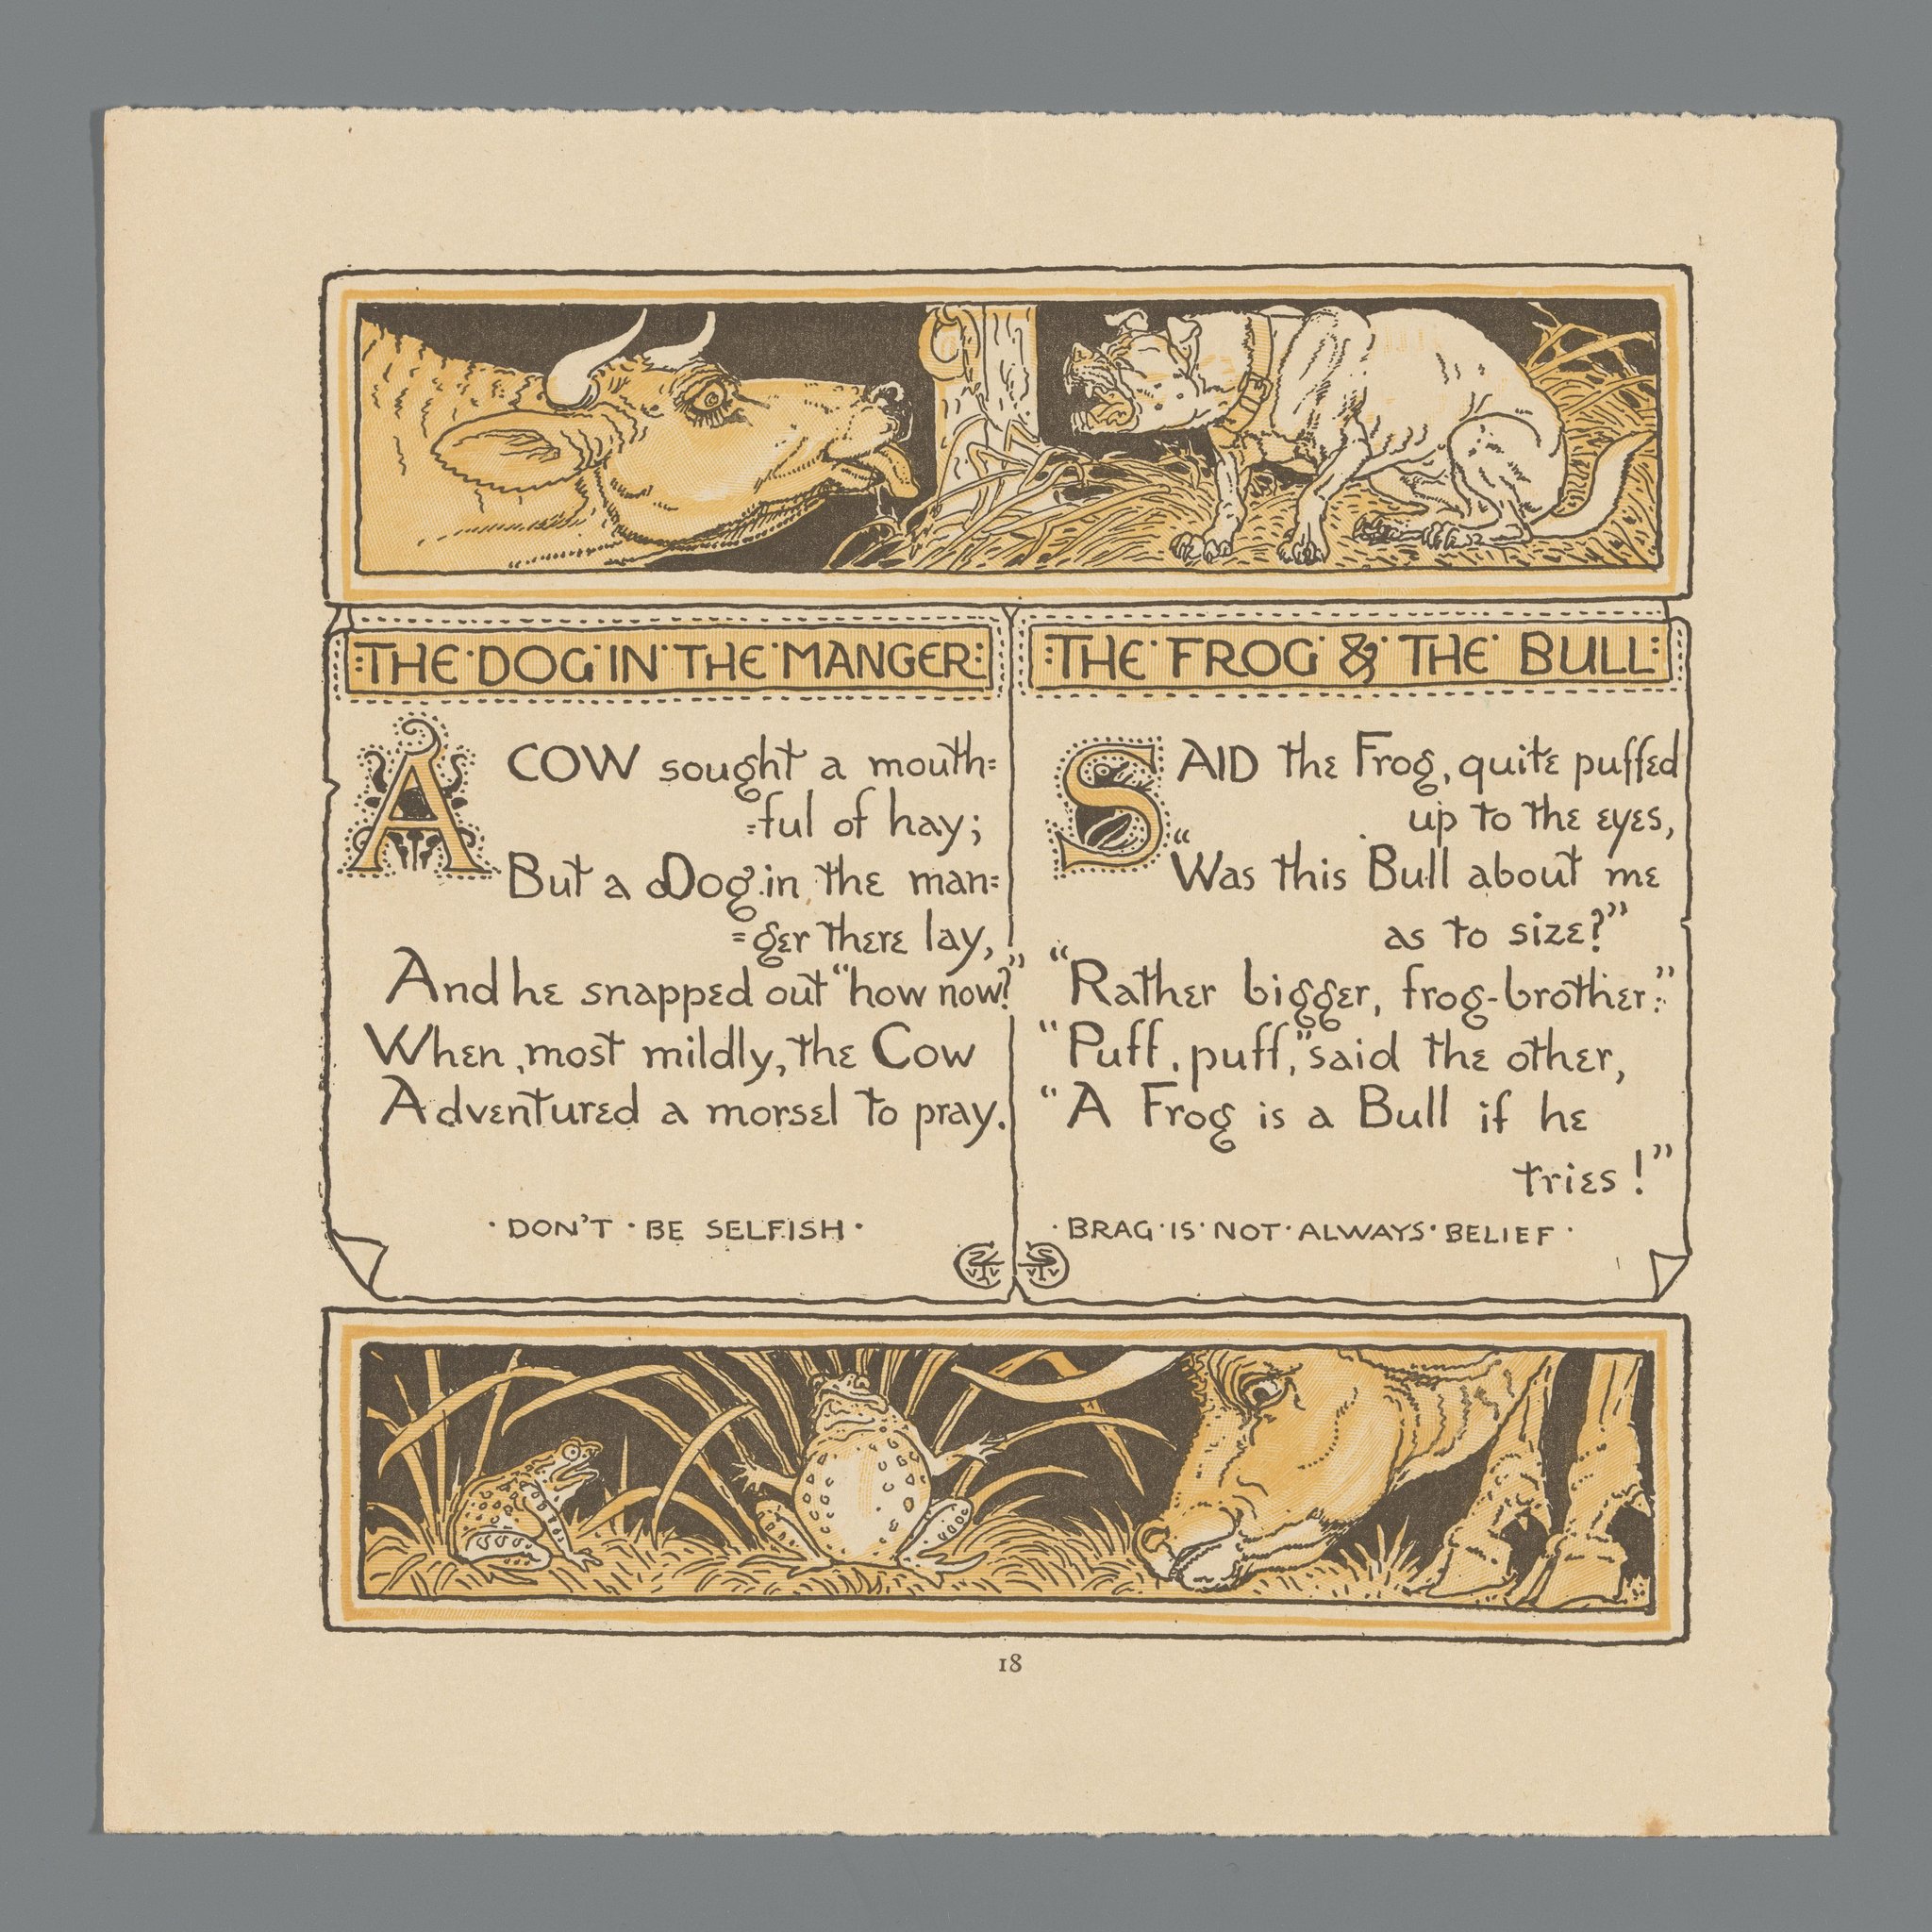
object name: print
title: The dog in the manger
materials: paper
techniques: wood engraving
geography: london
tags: fable of the frog and the cow, bovine cattle, dog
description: Prent uit: The baby's own Aesop being the fables condensed in rhyme. Londen: Routledge & Sons, 1887. Of een latere uitgave.